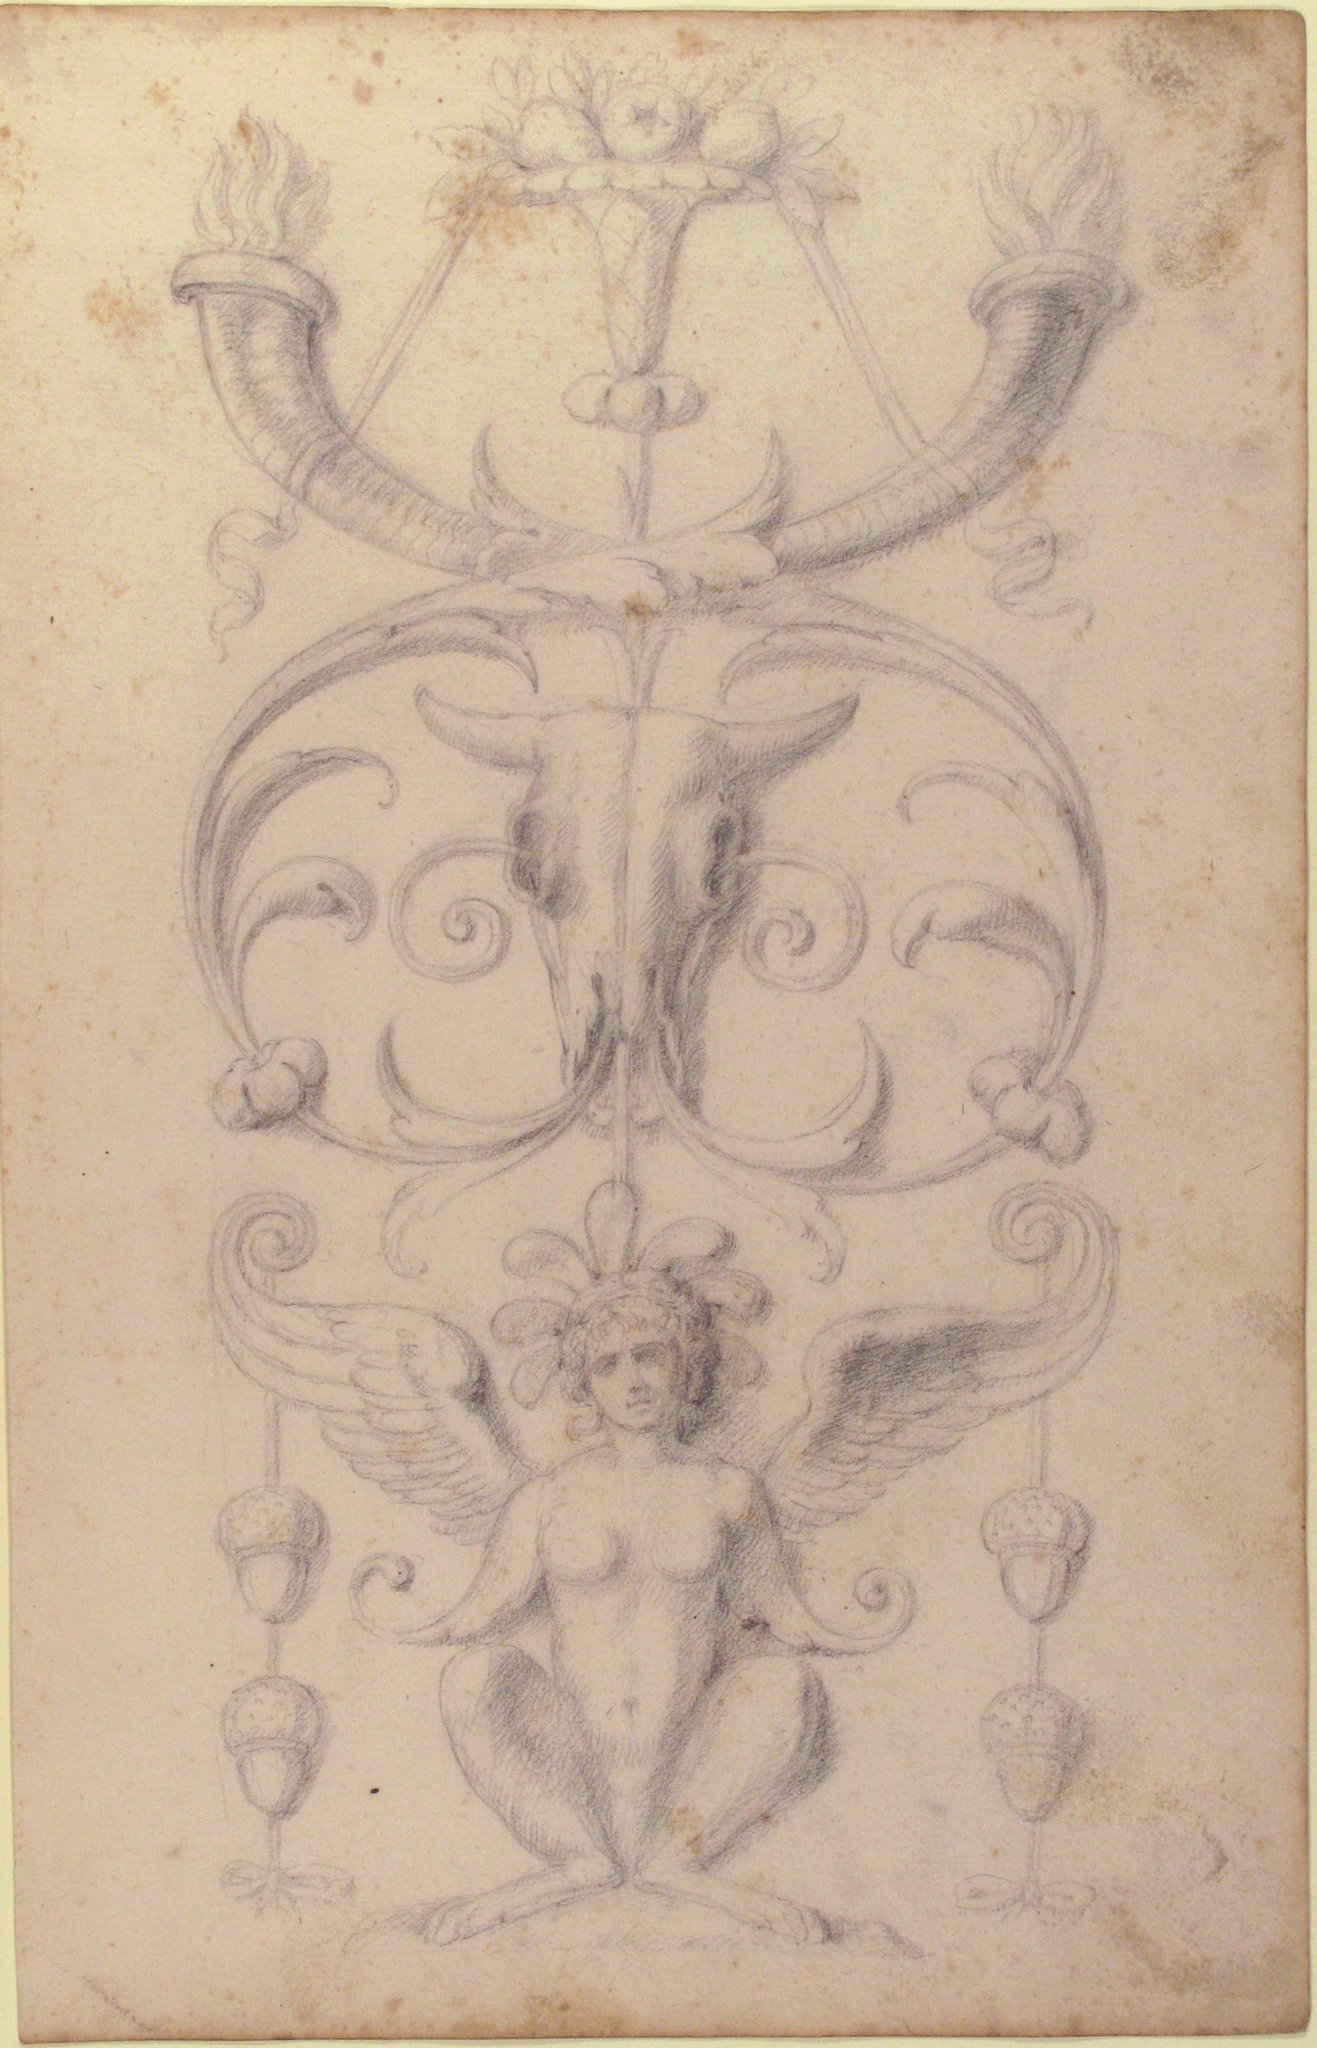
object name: drawing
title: Drawing of a Grotesque after a 16th-century Decorative Relief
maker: filippo cretoni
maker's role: artist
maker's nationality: italian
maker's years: 18-19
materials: chalk, graphite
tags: grotesques,ornament,mythical creatures